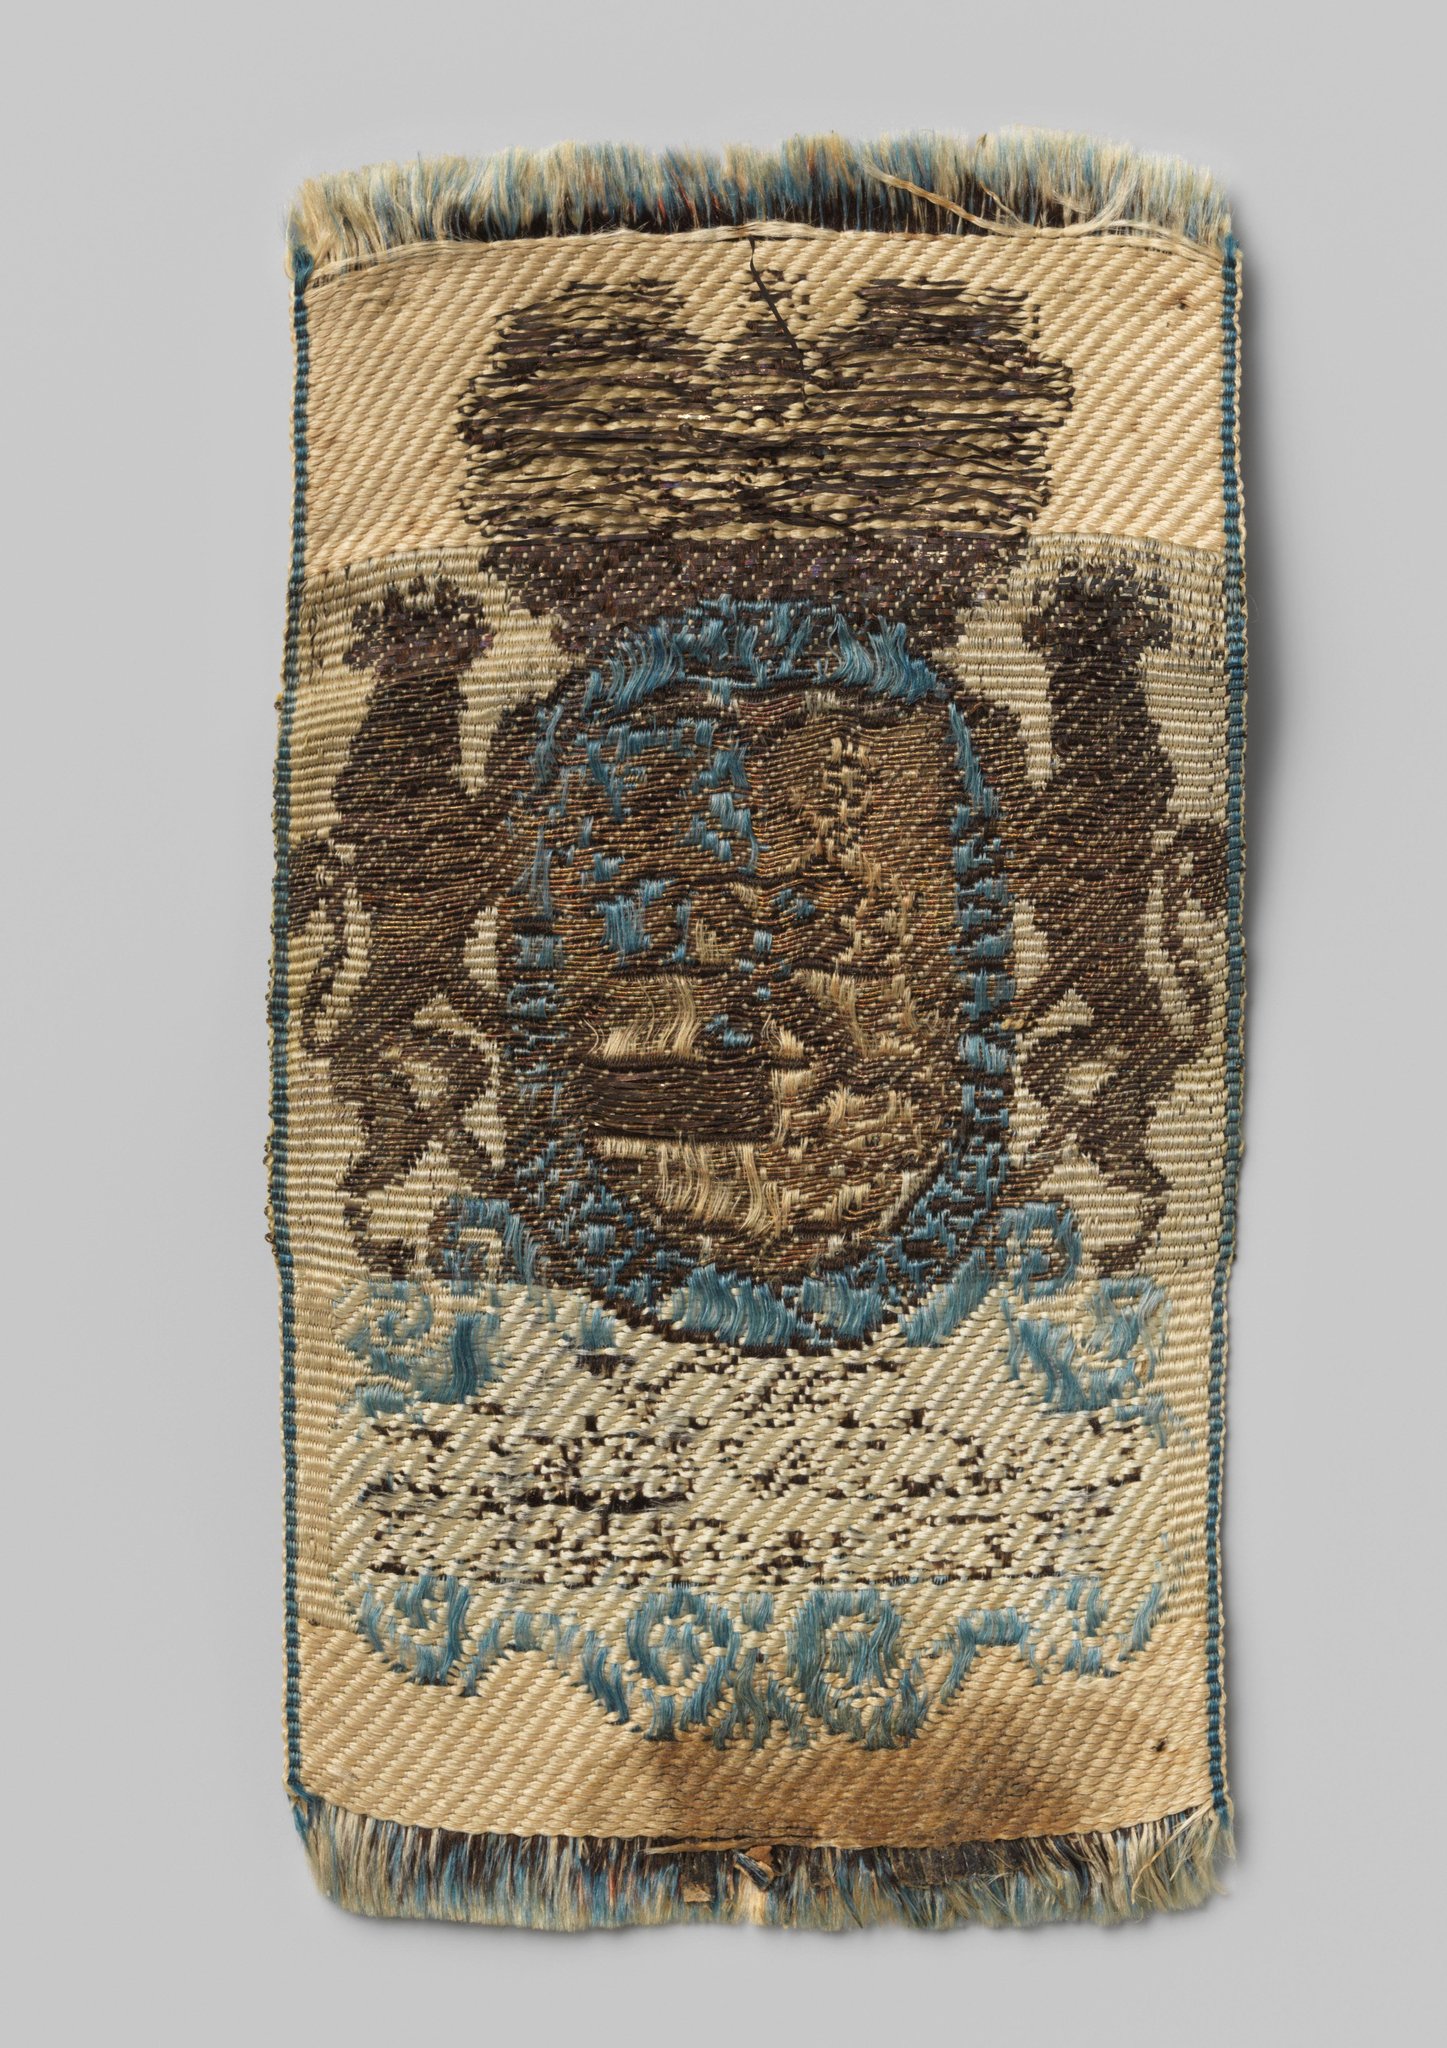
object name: ribbon material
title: Oranje-lint met wapen van Willem V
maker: Anonymous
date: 1750-1799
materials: silk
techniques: weave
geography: netherlands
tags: the hague, william v (prince of orange)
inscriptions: inscription: ‘Vivat / de Prins van Oranje / en graaf van Buren’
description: Oranje-lint met wapen van Willem V met opschrift. Rechthoekig lint waarop centraal een gekroond wapen met aan weerszijden een leeuw. Kleuren beige, bruin en blauw.